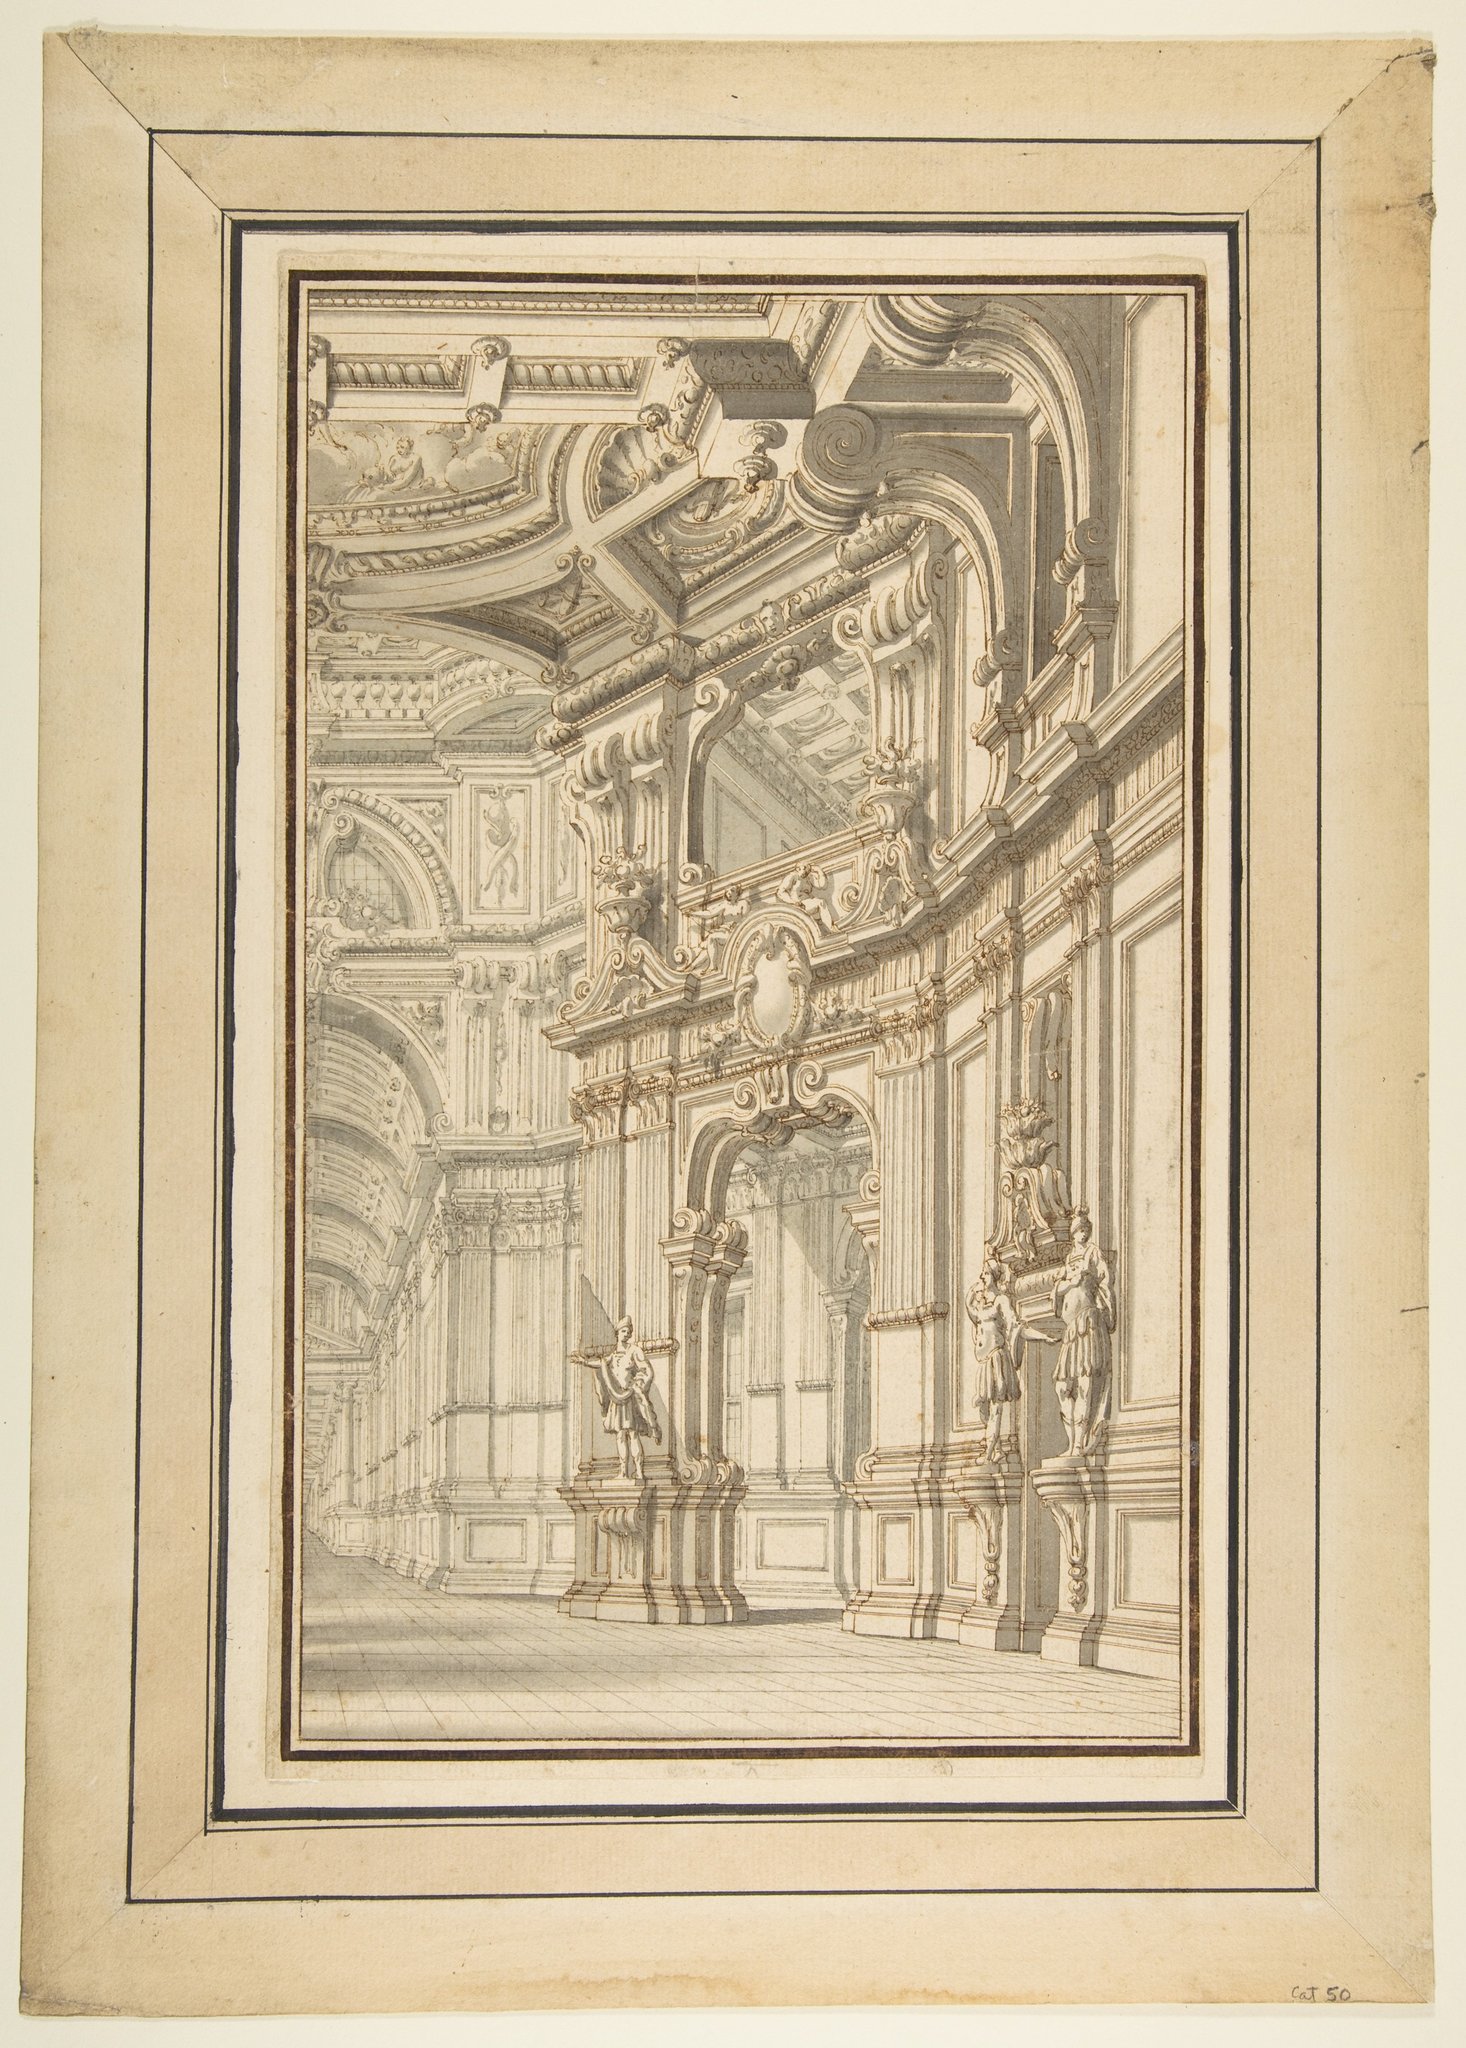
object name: drawing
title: Design for a Stage Set, Showing Right Half Only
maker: prospero zanichelli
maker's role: artist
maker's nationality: italian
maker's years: 1698-1772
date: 1698-1772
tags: stage design